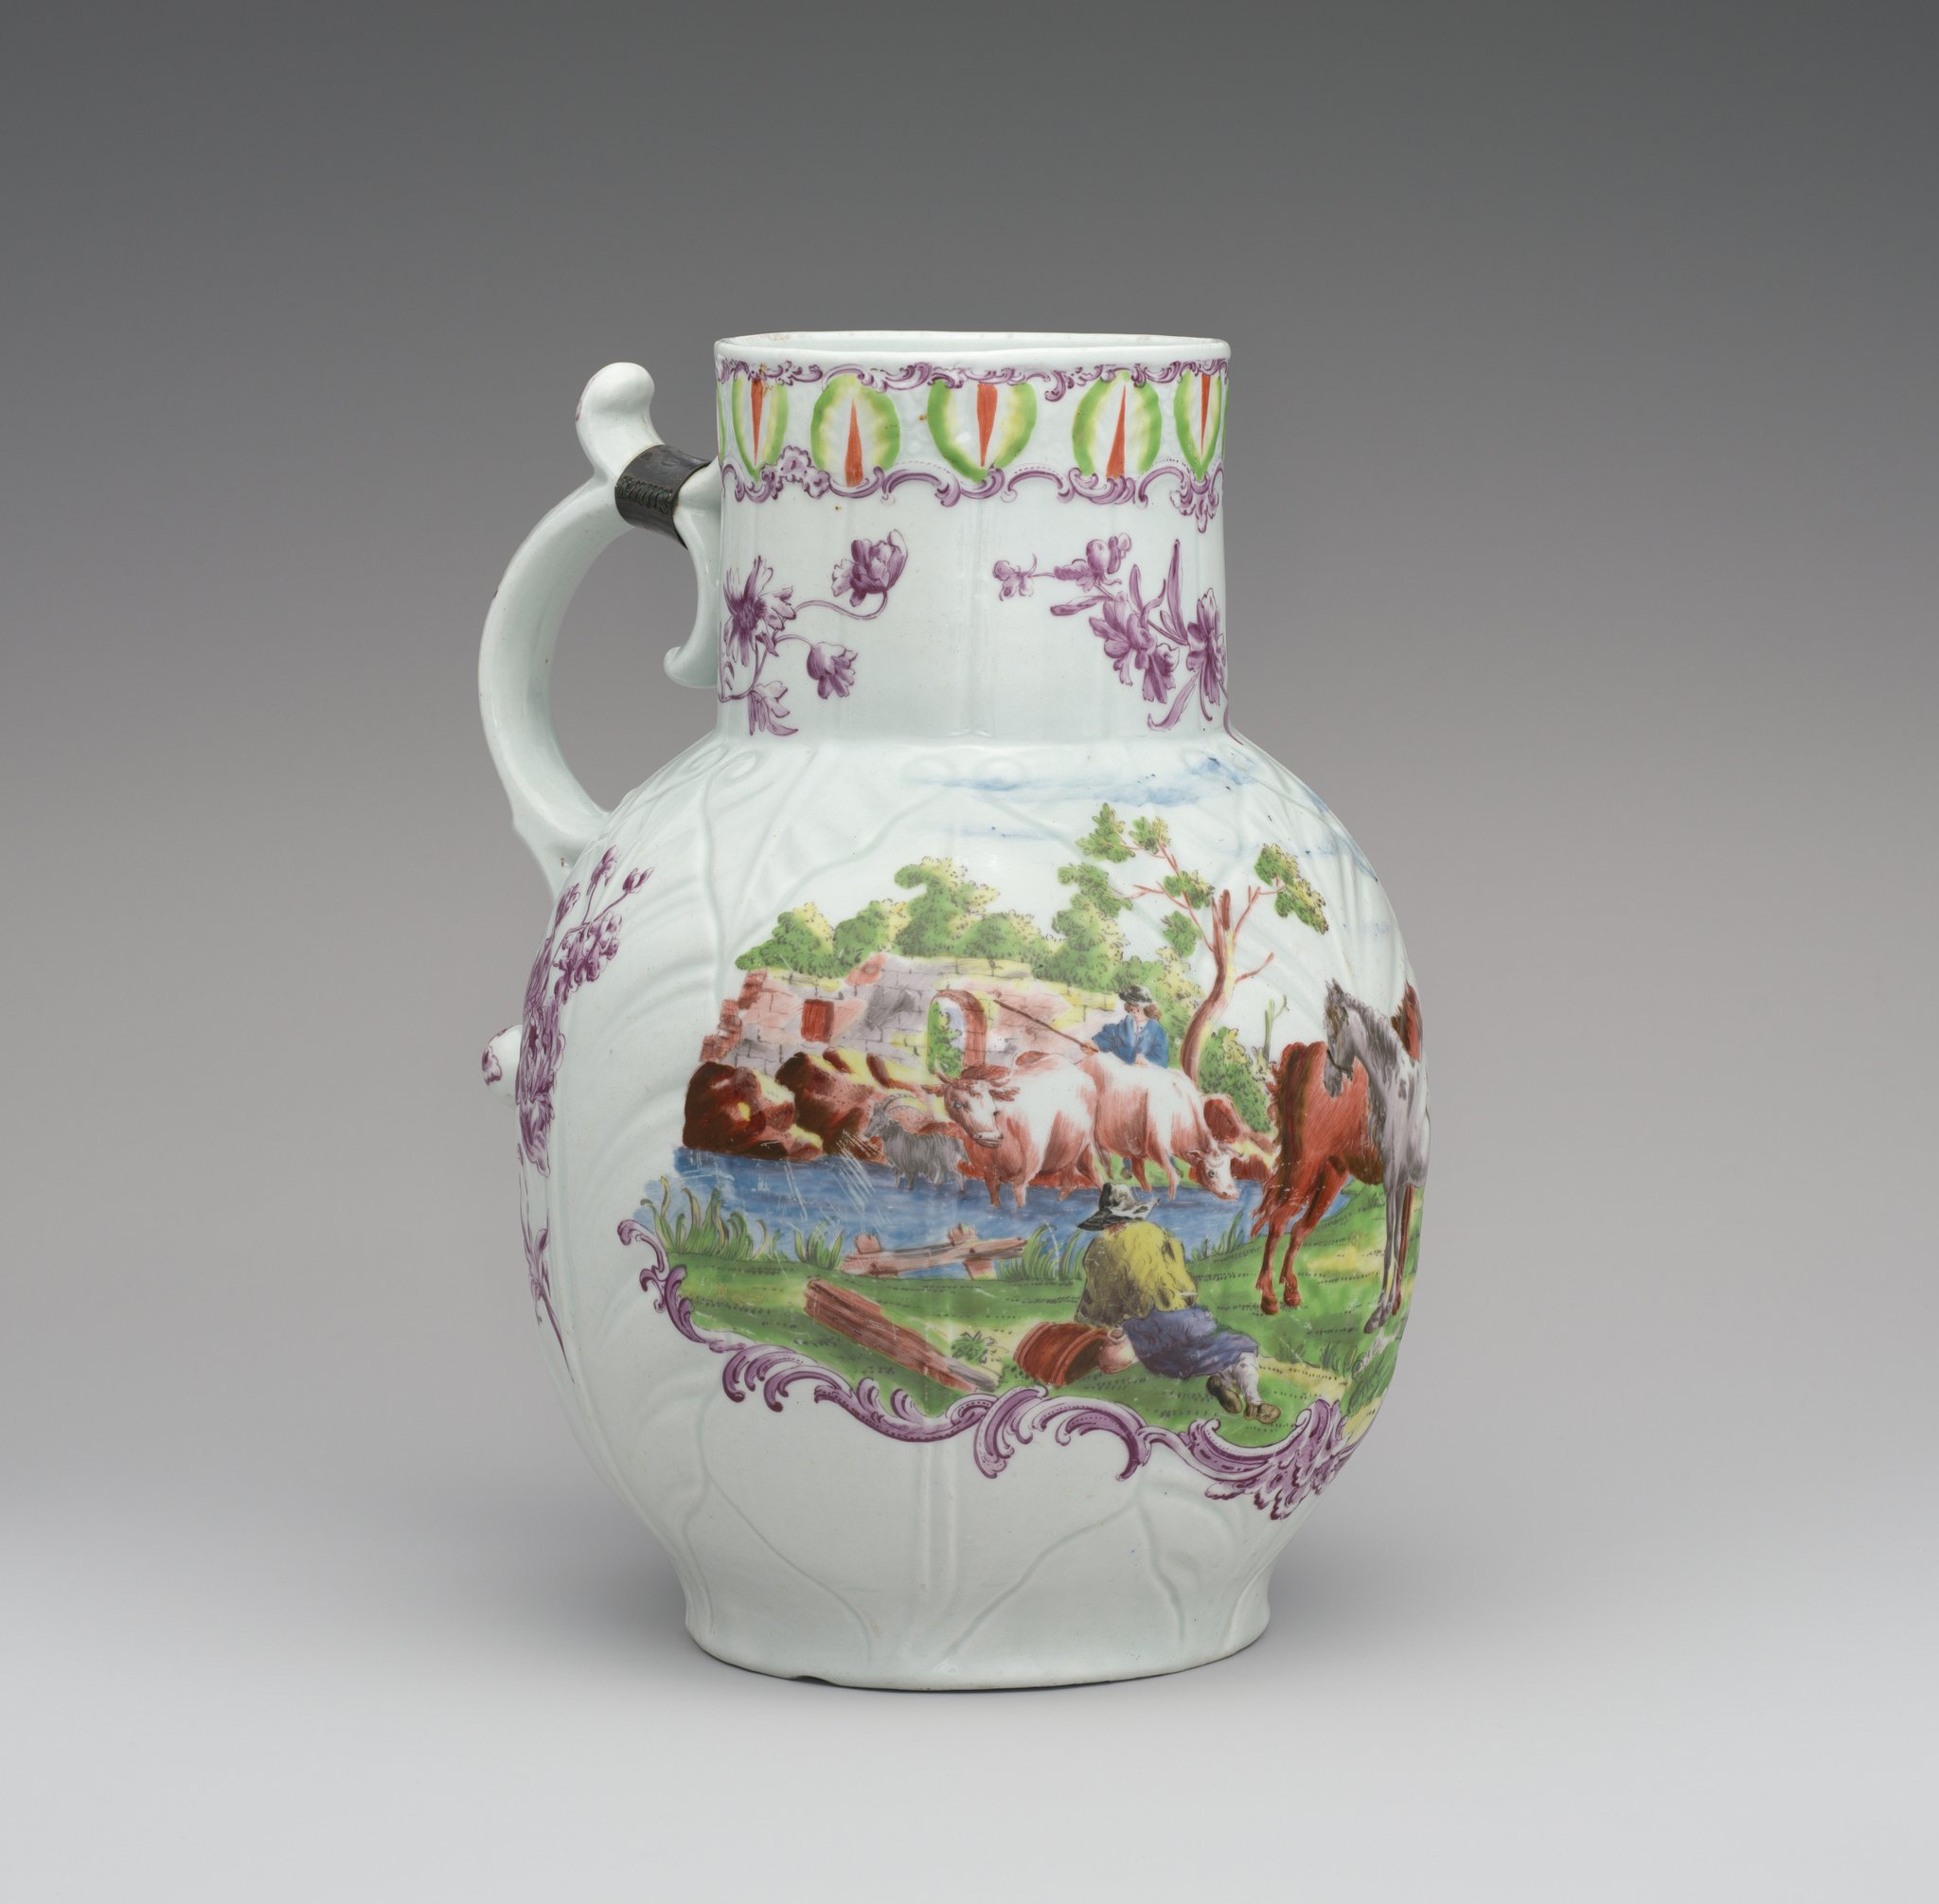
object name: jug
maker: worcester factory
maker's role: factory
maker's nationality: british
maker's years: 1751-2008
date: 1760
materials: soft paste porcelain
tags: cows,horses